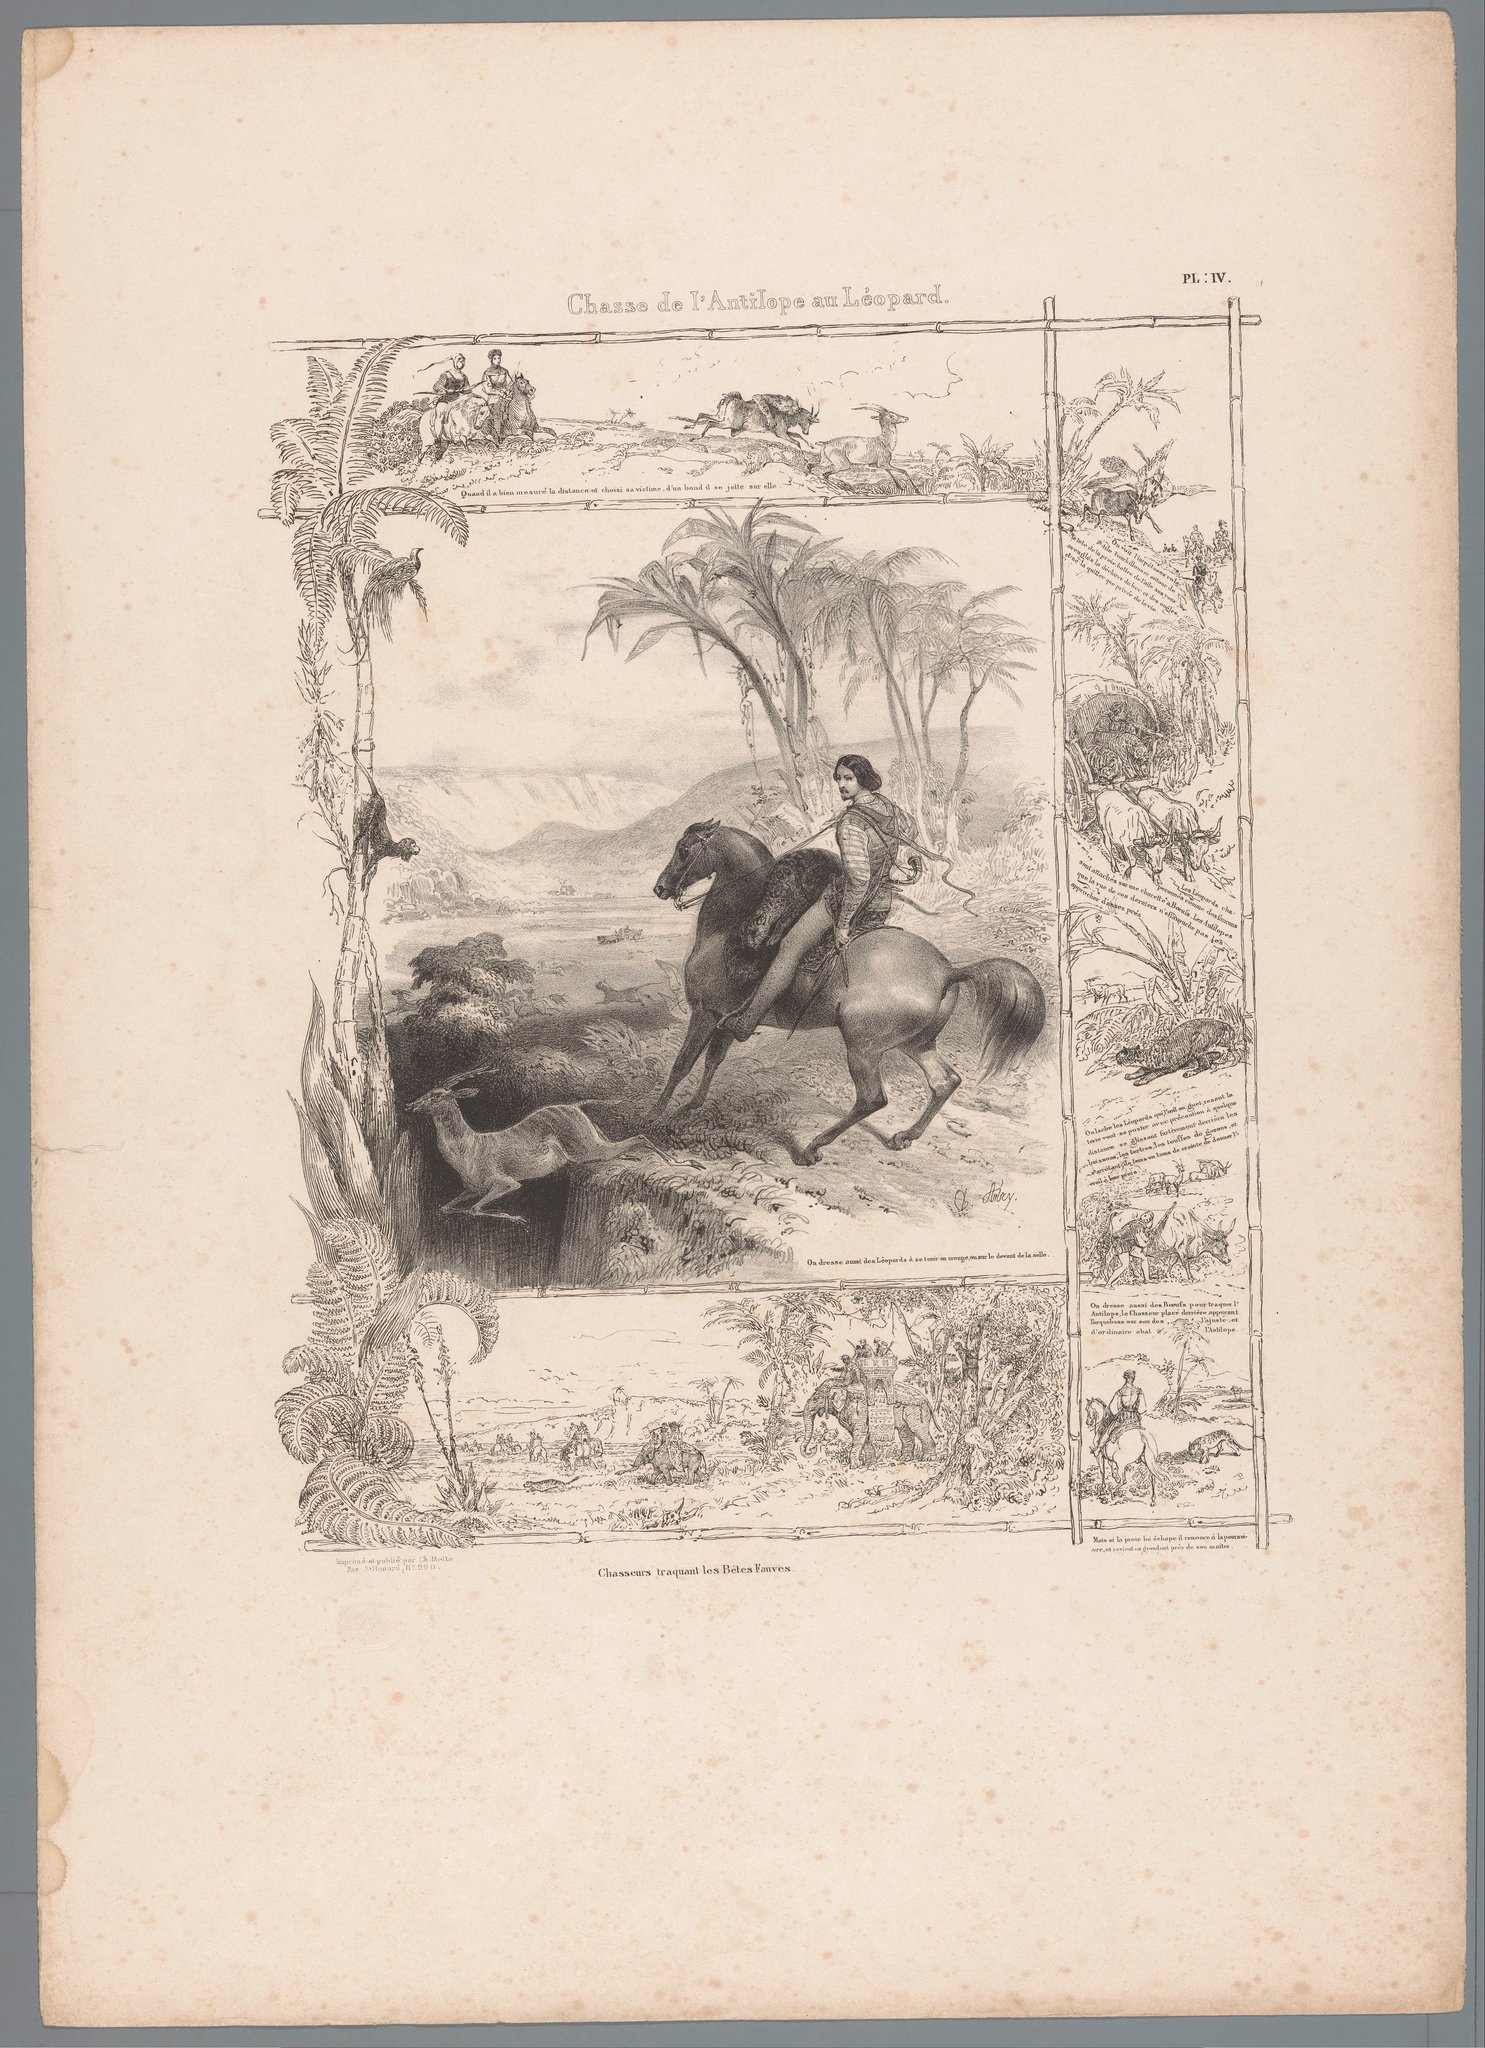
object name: print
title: Chasse de l'antilope au léopard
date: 1836-1837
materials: paper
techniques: lithography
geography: paris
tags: beasts of prey, predatory animals: leopard, hunt ~ hoofed animals, hoofed animals: antelope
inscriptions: check stamp: Lugt 1828c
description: Deze prent maakt deel uit van een omslag met twaalf prenten. Rondom de hoofdvoorstelling worden diverse jachttechnieken uitgelegd in woord en beeld.